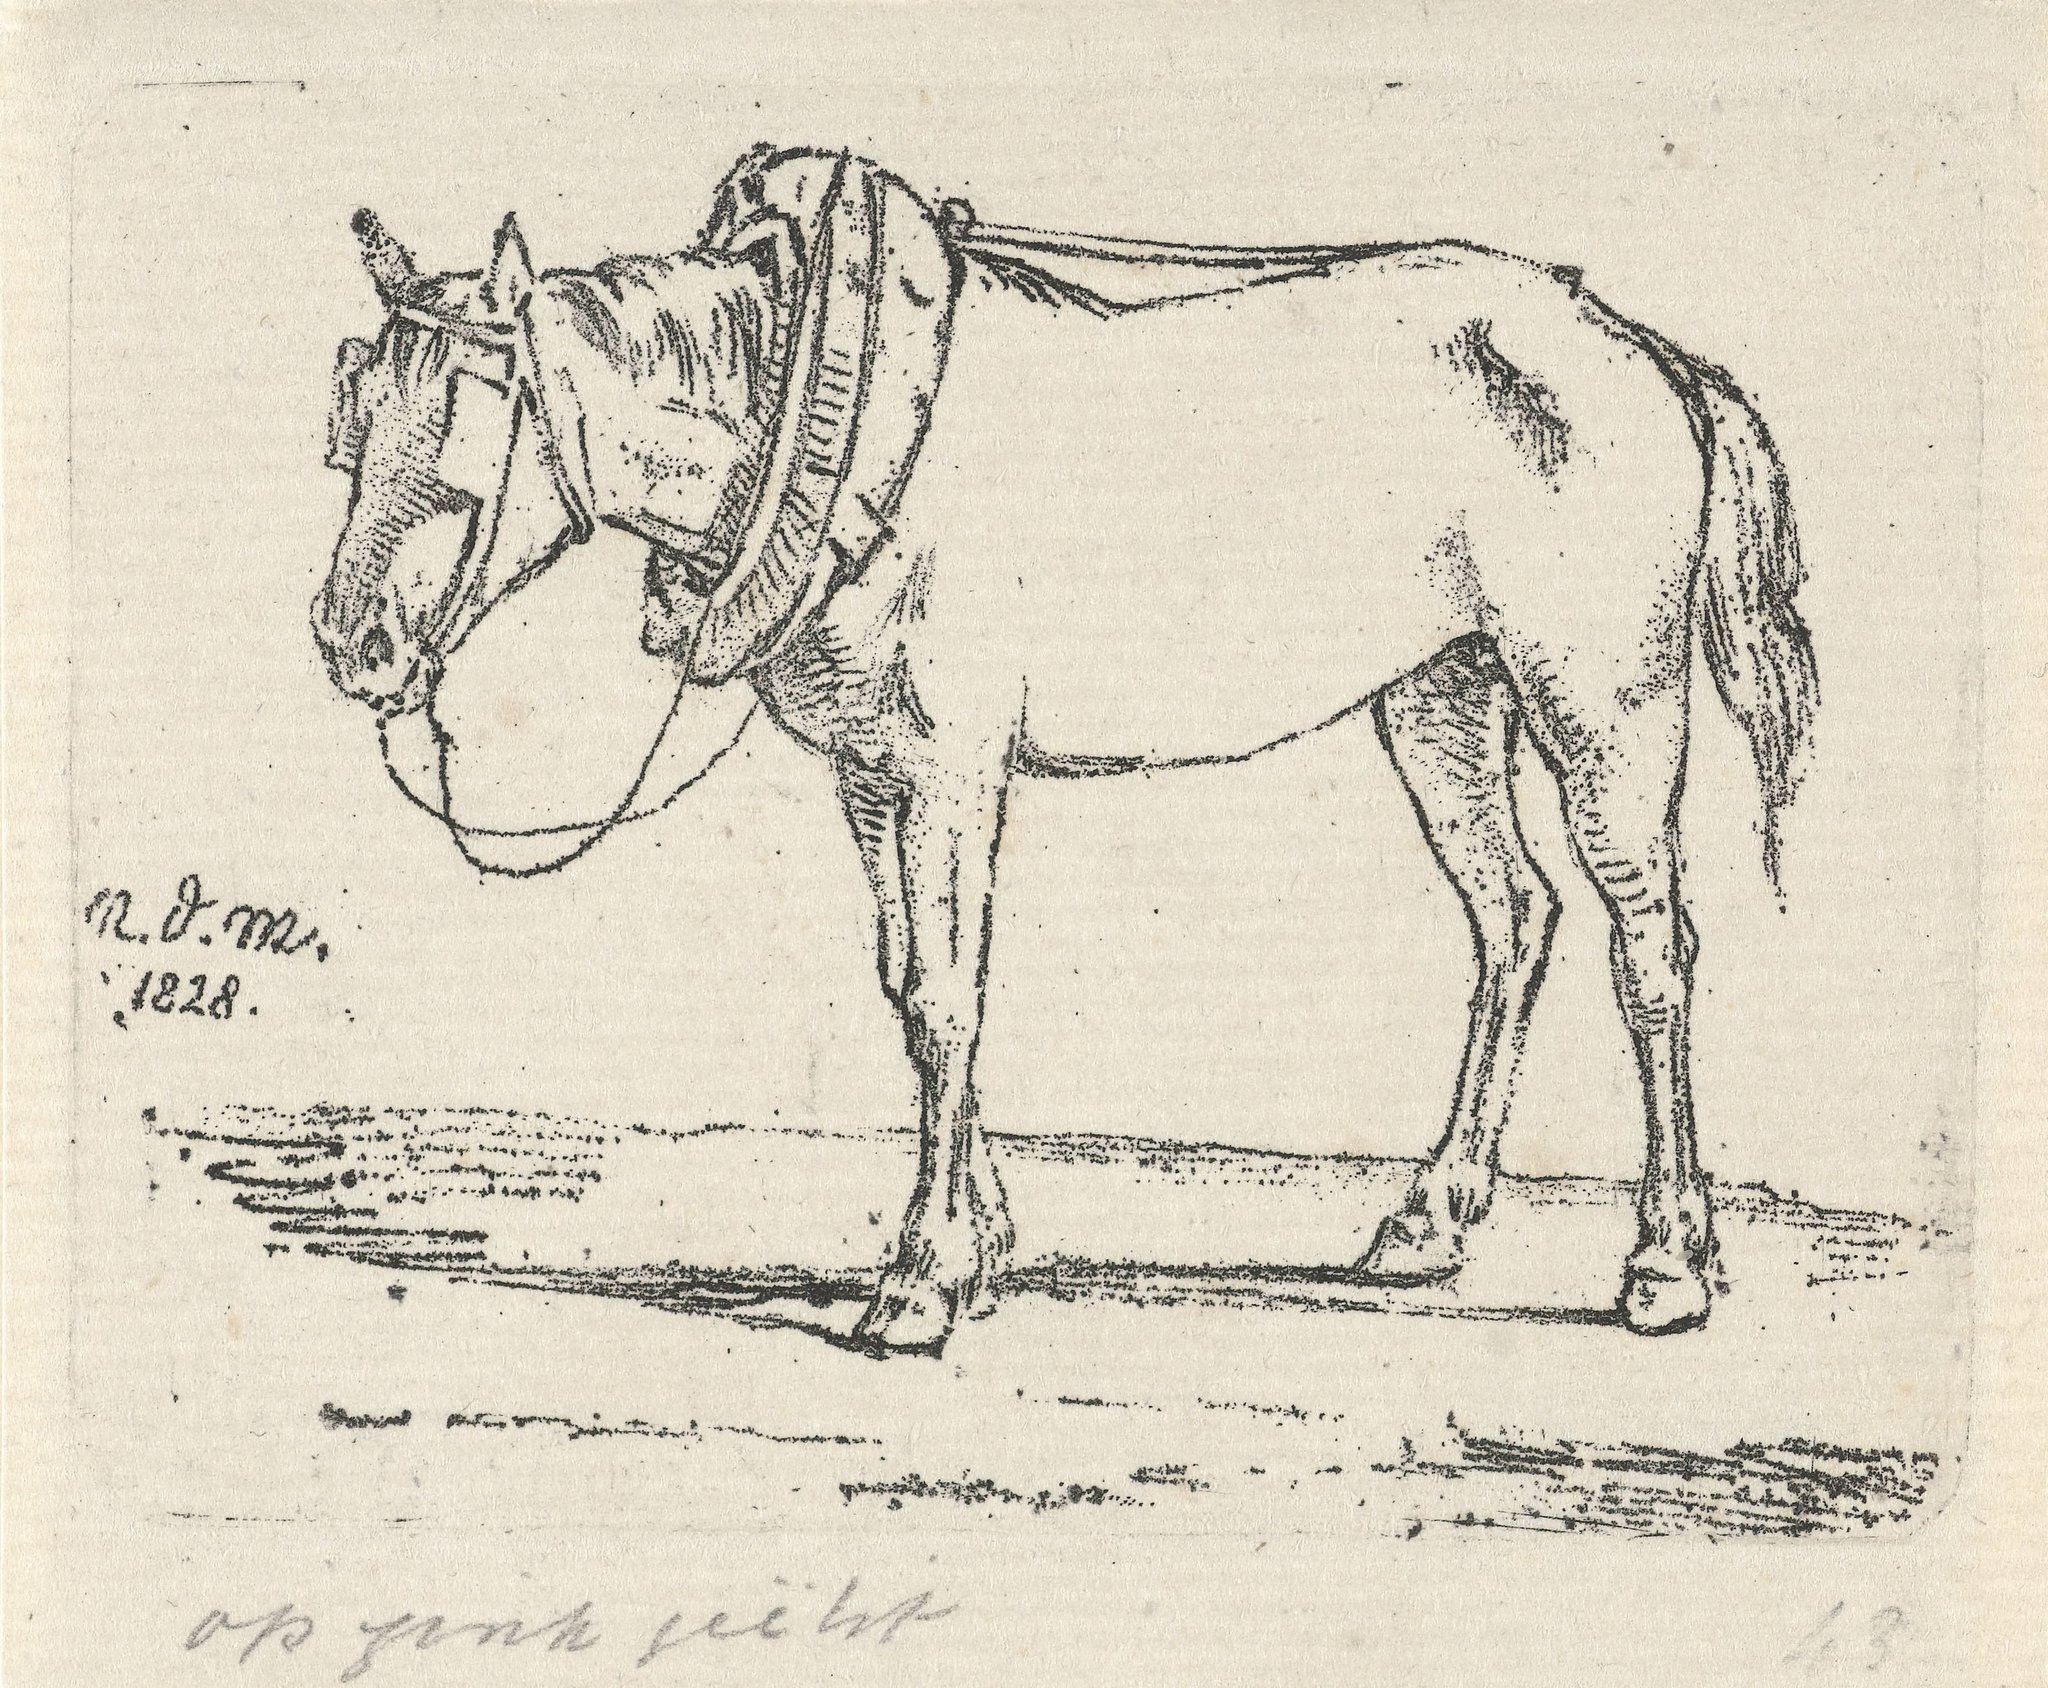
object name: print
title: Opgetuigd paard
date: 1828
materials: paper, pencil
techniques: etching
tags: horse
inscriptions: collector's mark: Lugt 2227, inscription: ‘op zink geëtst’